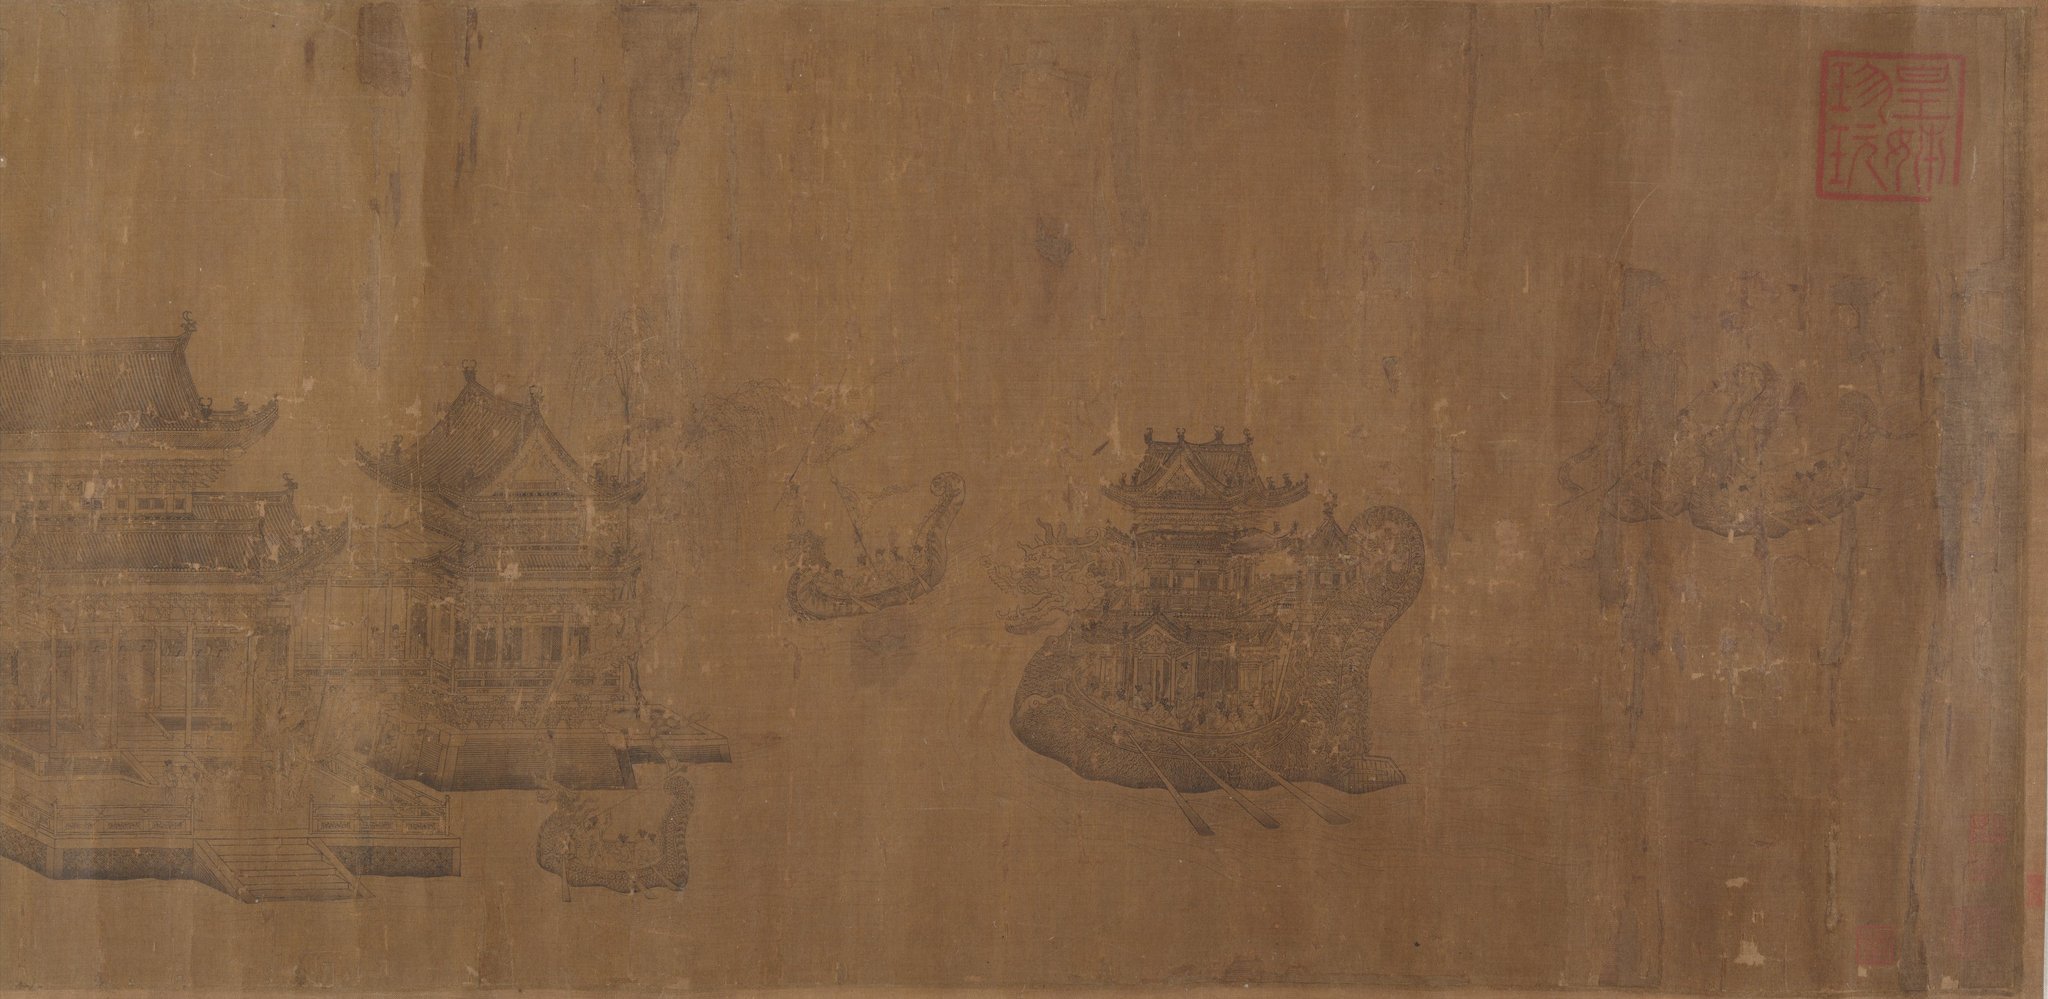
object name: handscroll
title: Dragon Boat Regatta on Jinming Lake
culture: chinese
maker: wang zhenpeng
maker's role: artist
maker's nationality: chinese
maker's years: 1265-1340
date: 1301-1400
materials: ink, silk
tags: lakes,boats